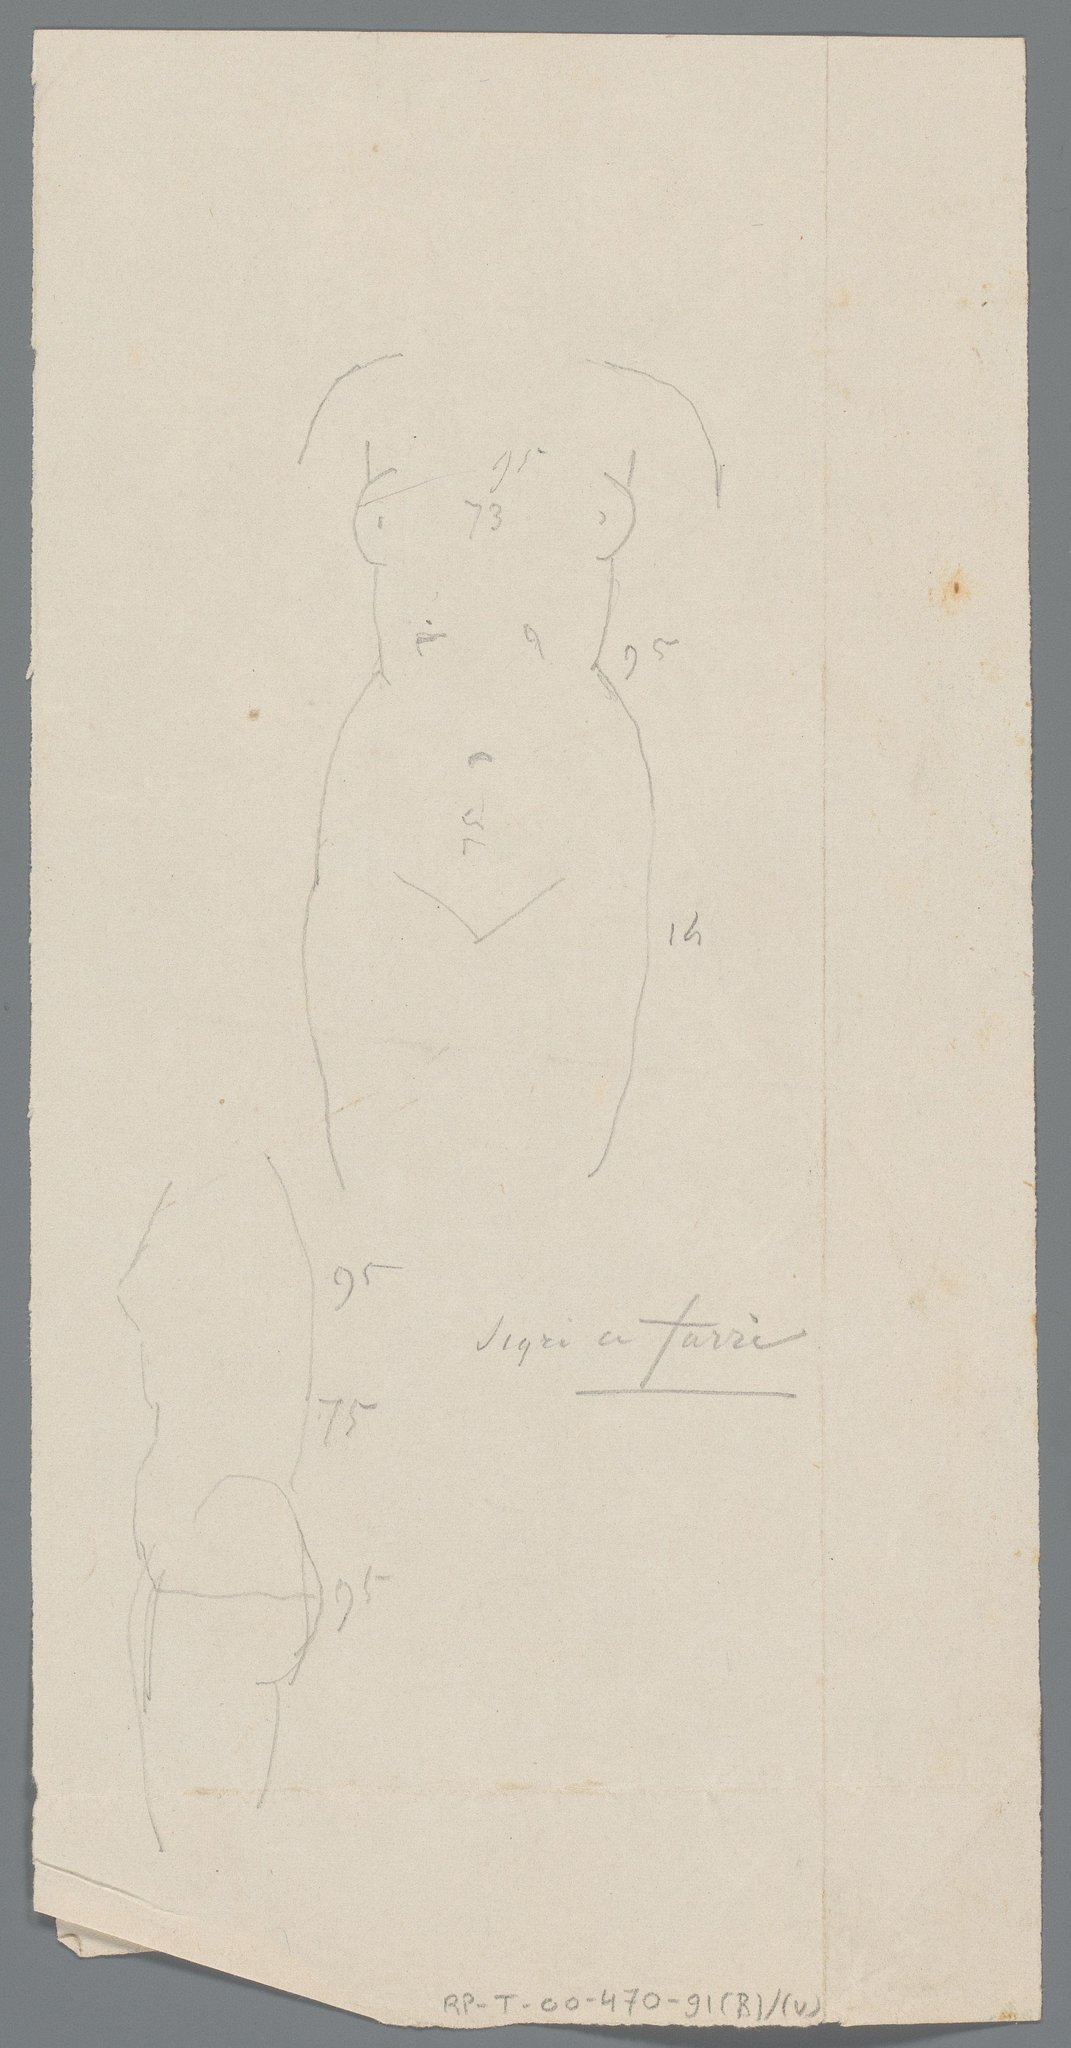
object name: drawing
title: Figuurstudies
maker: jacobus everhardus josephus van den berg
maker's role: draughtsman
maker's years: 1802-1861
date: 1812-1861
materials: paper, pencil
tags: the (nude) human figure; 'corpo humano' (ripa) - aa - female human figure